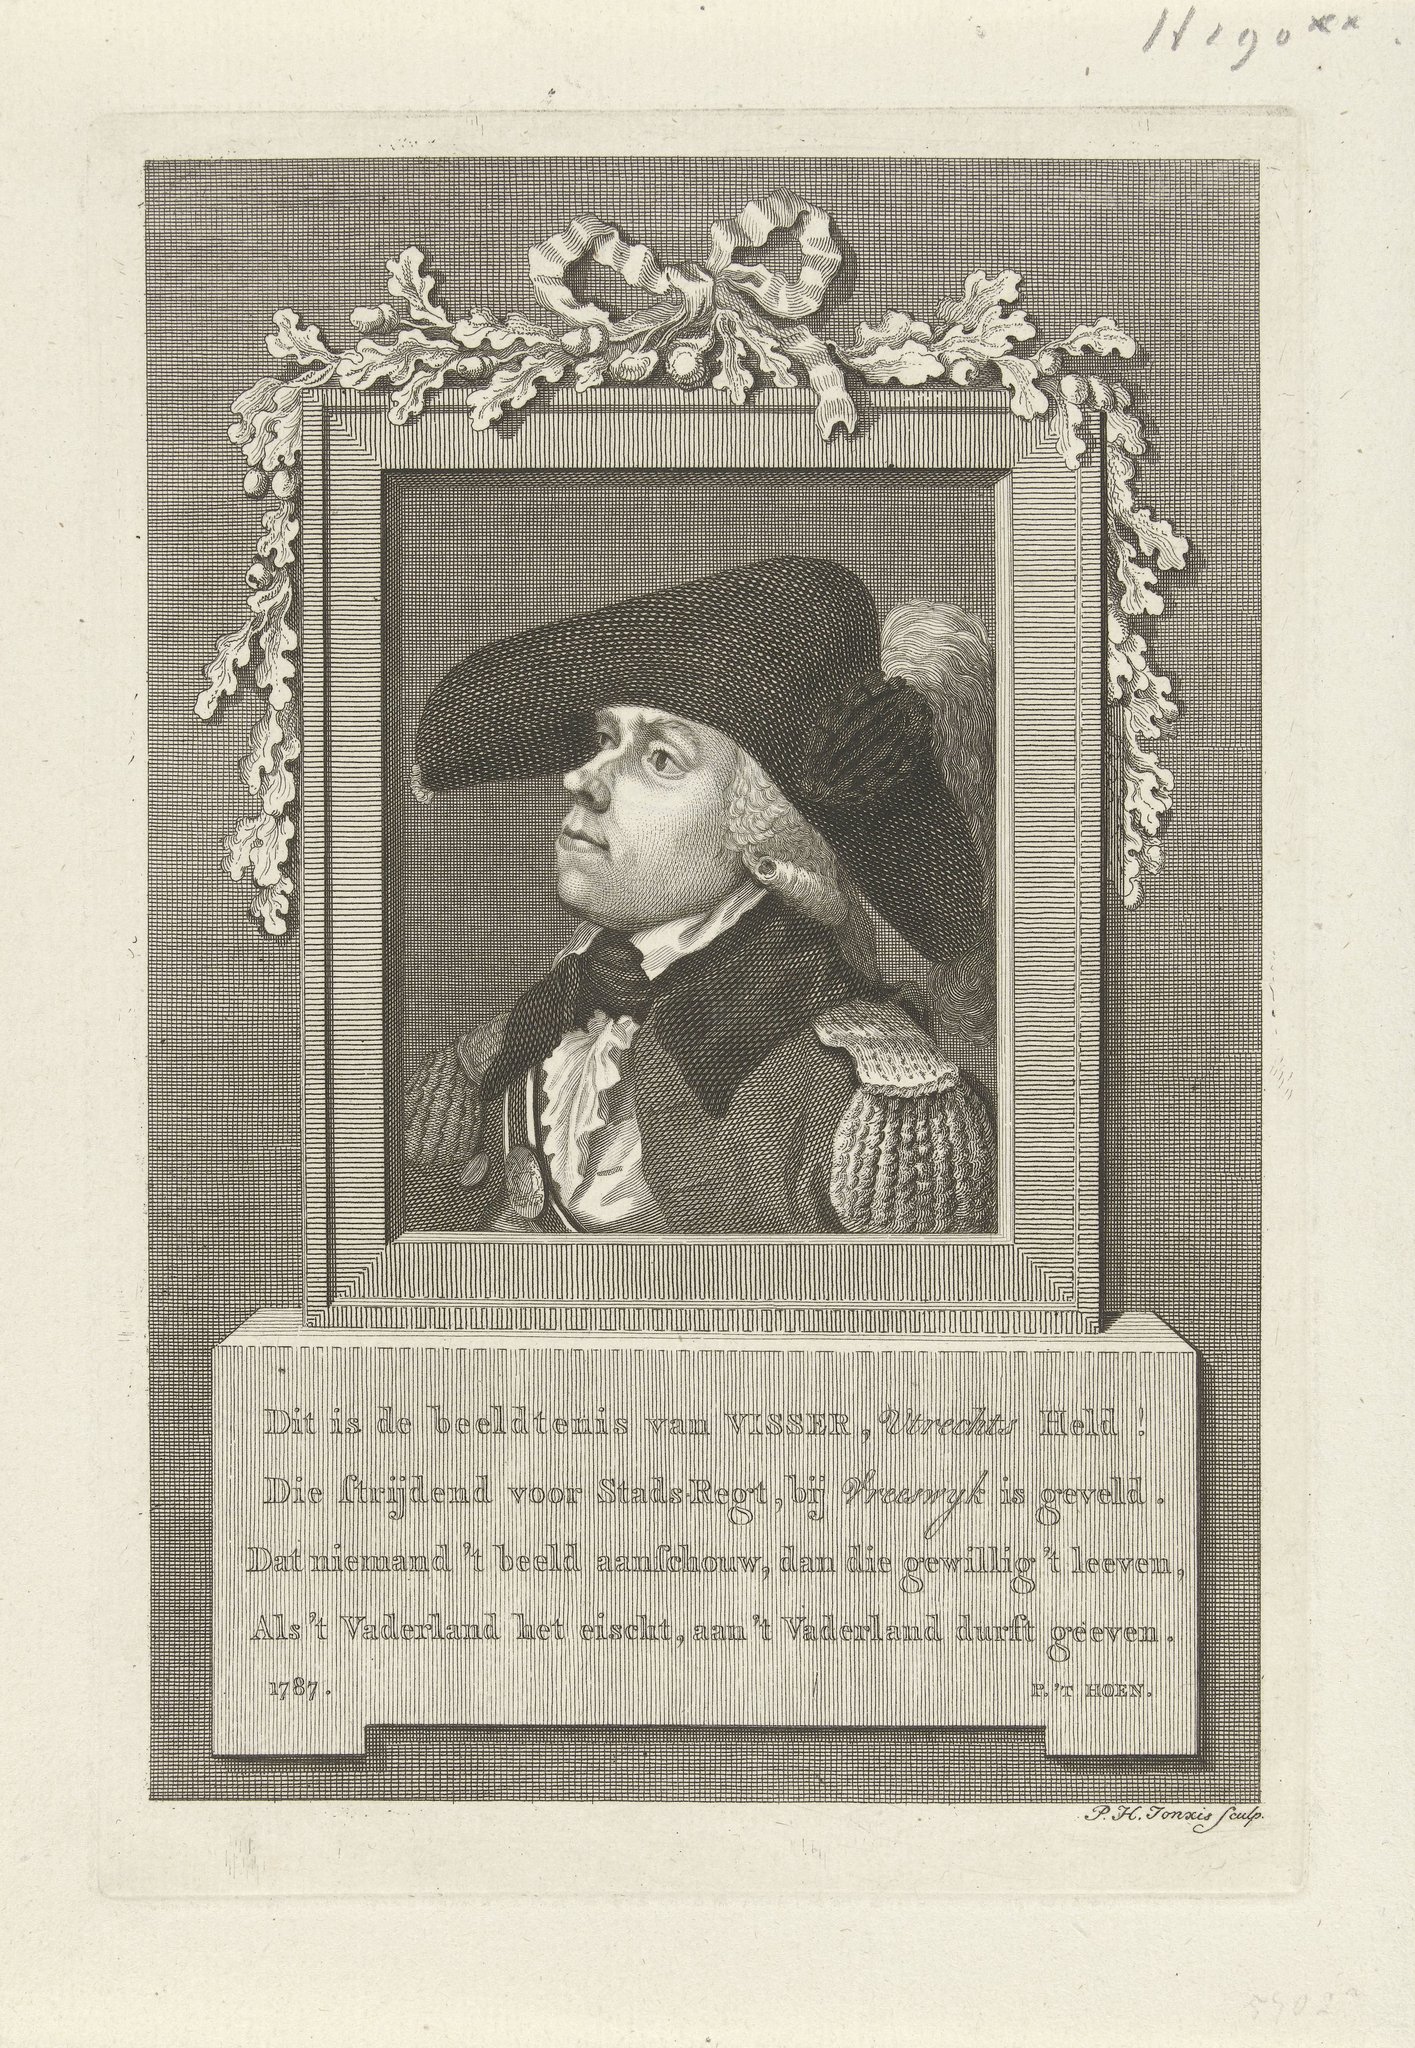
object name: print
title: Portret van Cornelis Govert Visscher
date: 1787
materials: paper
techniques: engraving, etching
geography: utrecht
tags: vreeswijk, legeraanvoerder, cornelis govert visscher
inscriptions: collector's mark: Lugt 2760, collector's mark: Lugt 2228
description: Busteportret van de commandant Cornelis Govert Visscher. Het portret is gevat in een rechthoekige omlijsting versierd met eikenbladeren en een strik. In het kader een vierregelig gedicht in het Nederlands.